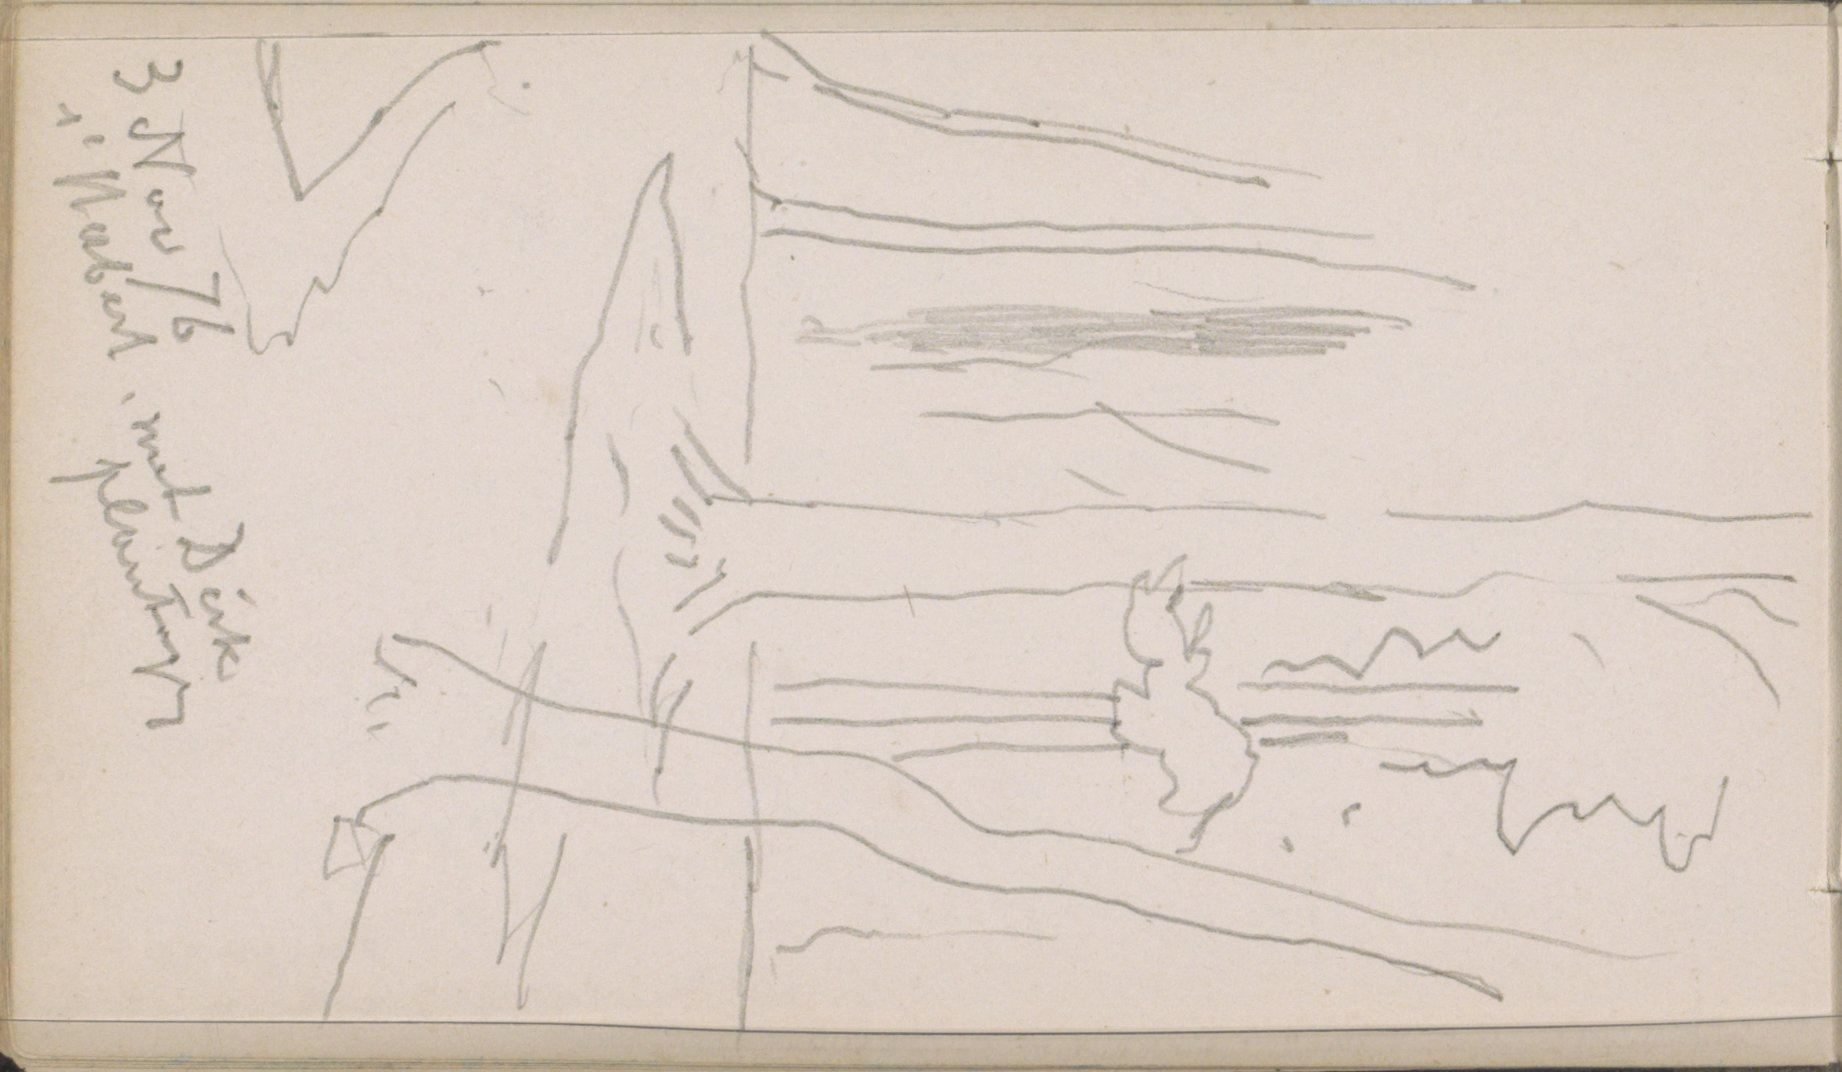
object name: sketchbook leaf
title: Polder bij de Rotte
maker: johannes tavenraat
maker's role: draughtsman, painter, print maker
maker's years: 1809-1881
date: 1809-1876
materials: paper, pencil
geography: rotte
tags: polder, reclaimed land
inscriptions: date and inscription: ‘nieuwe polder/ maar Nieuwerkade/ van de Rotte oneindig door [...] 20 Sept 76.’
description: Blad 41 verso uit een schetsboek met 46 bladen.